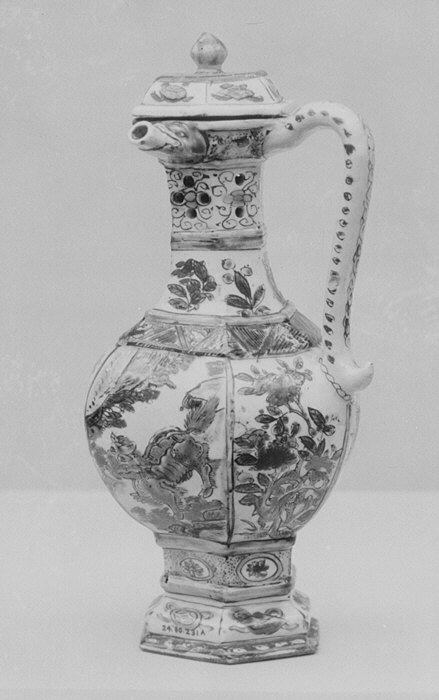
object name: ewer with cover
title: Ewer with cover (one of a pair)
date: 1715-1730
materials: hard paste porcelain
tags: flowers